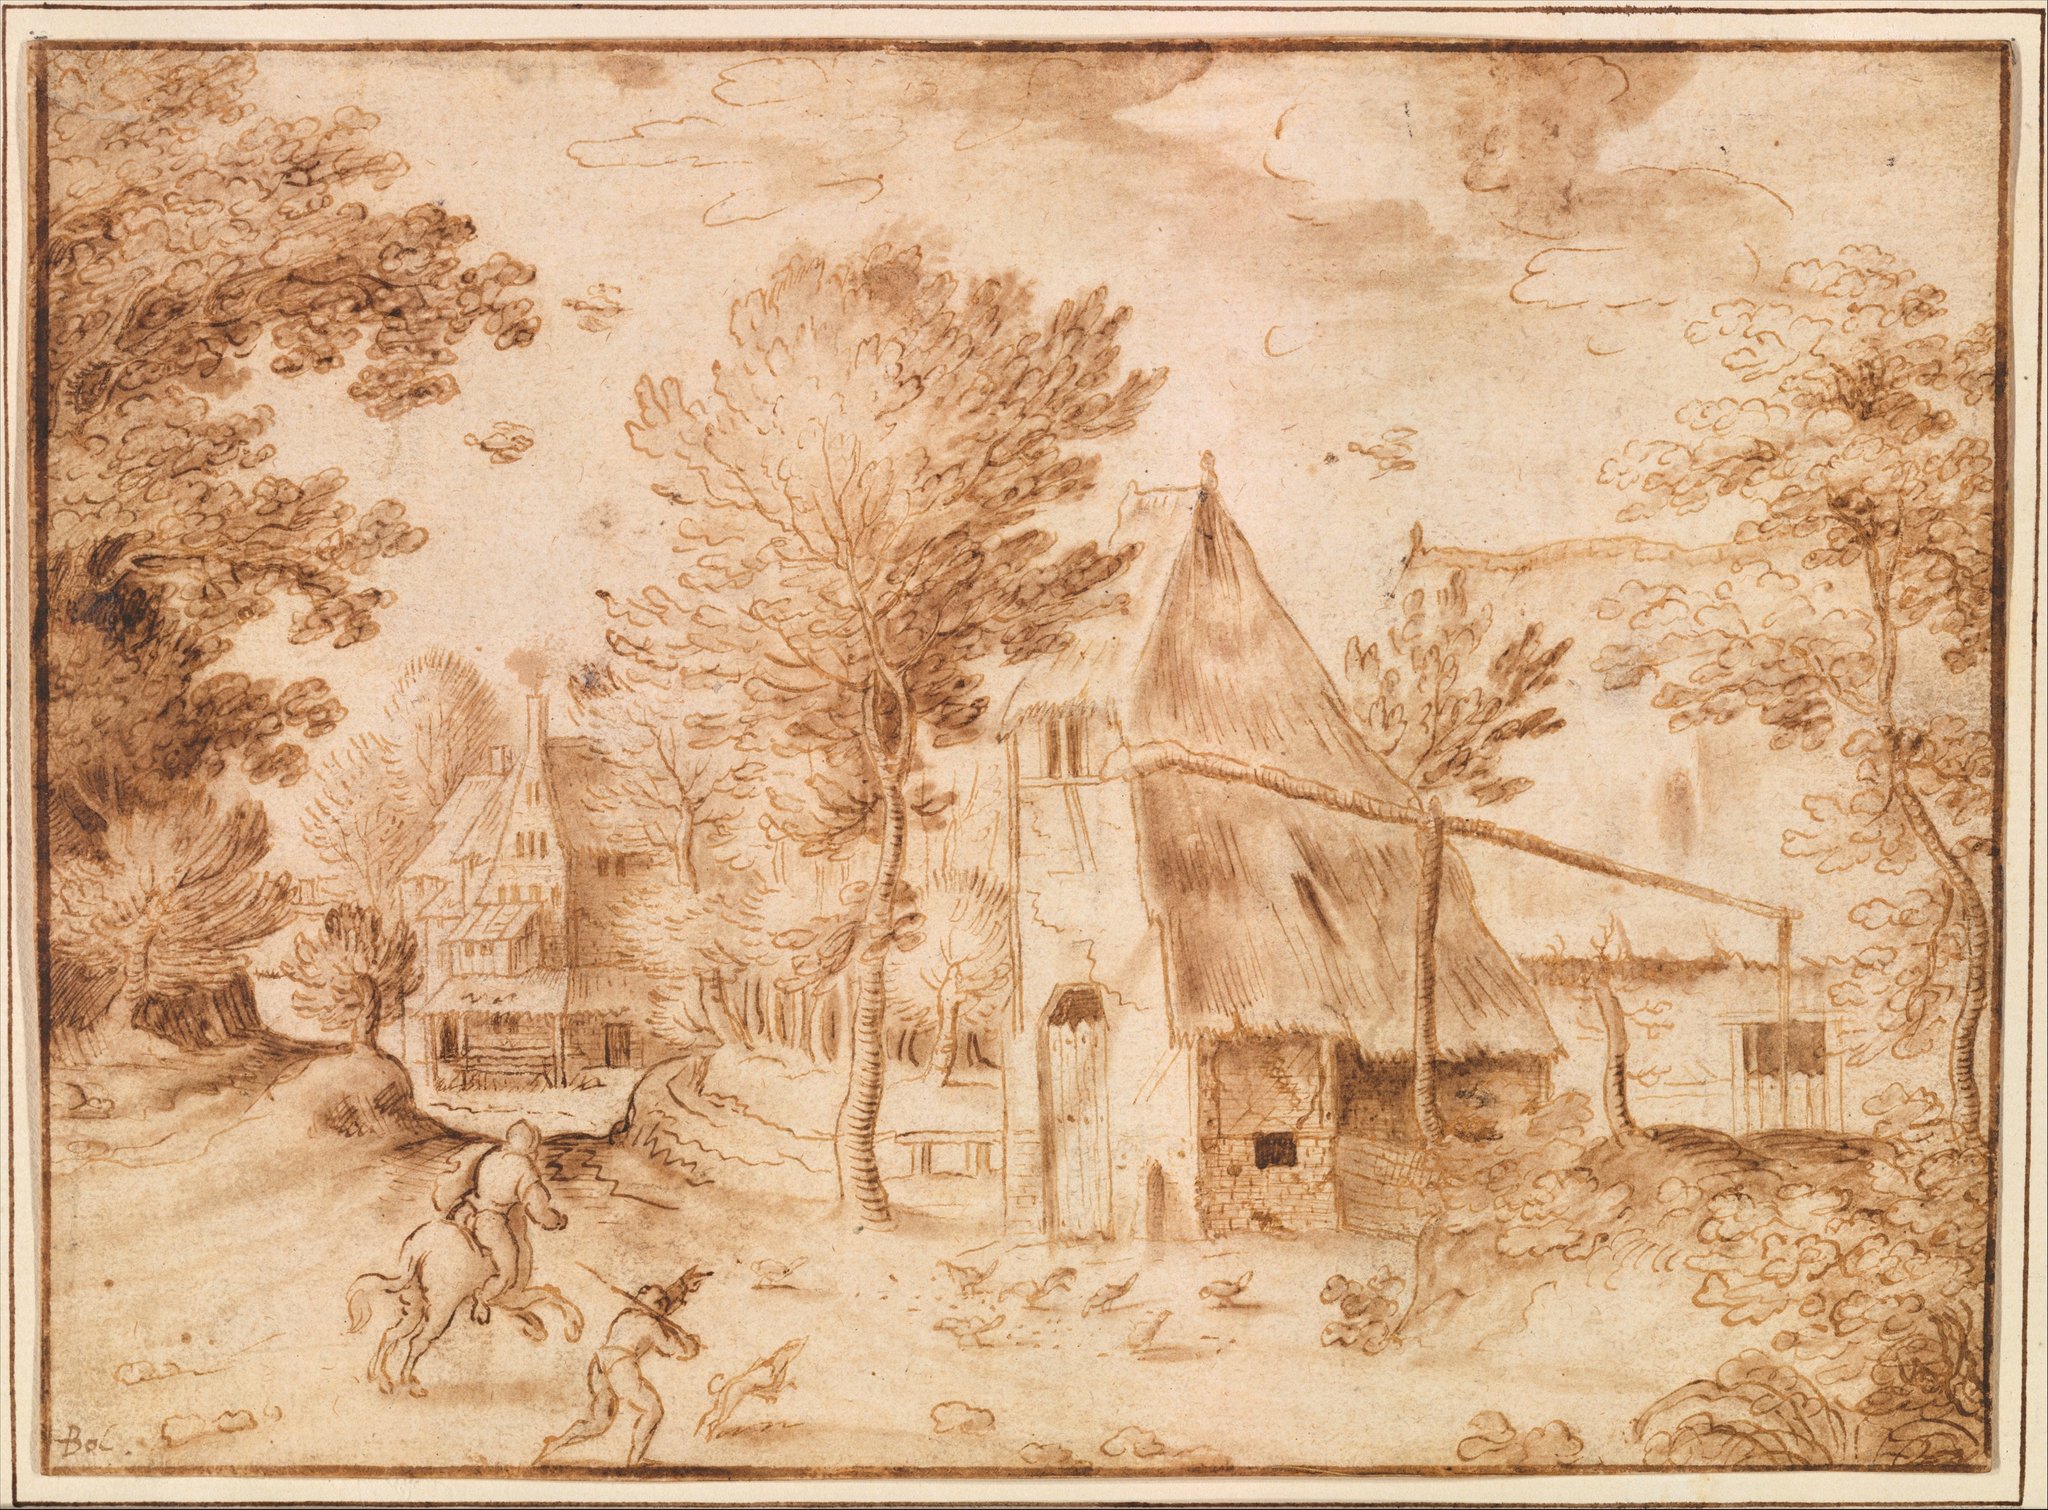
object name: drawing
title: Travelers at a Village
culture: flemish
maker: copy after joos van liere (master of the small landscapes)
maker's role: artist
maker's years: 1570-1630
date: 1570-1629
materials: ink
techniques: pen, wash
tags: villages